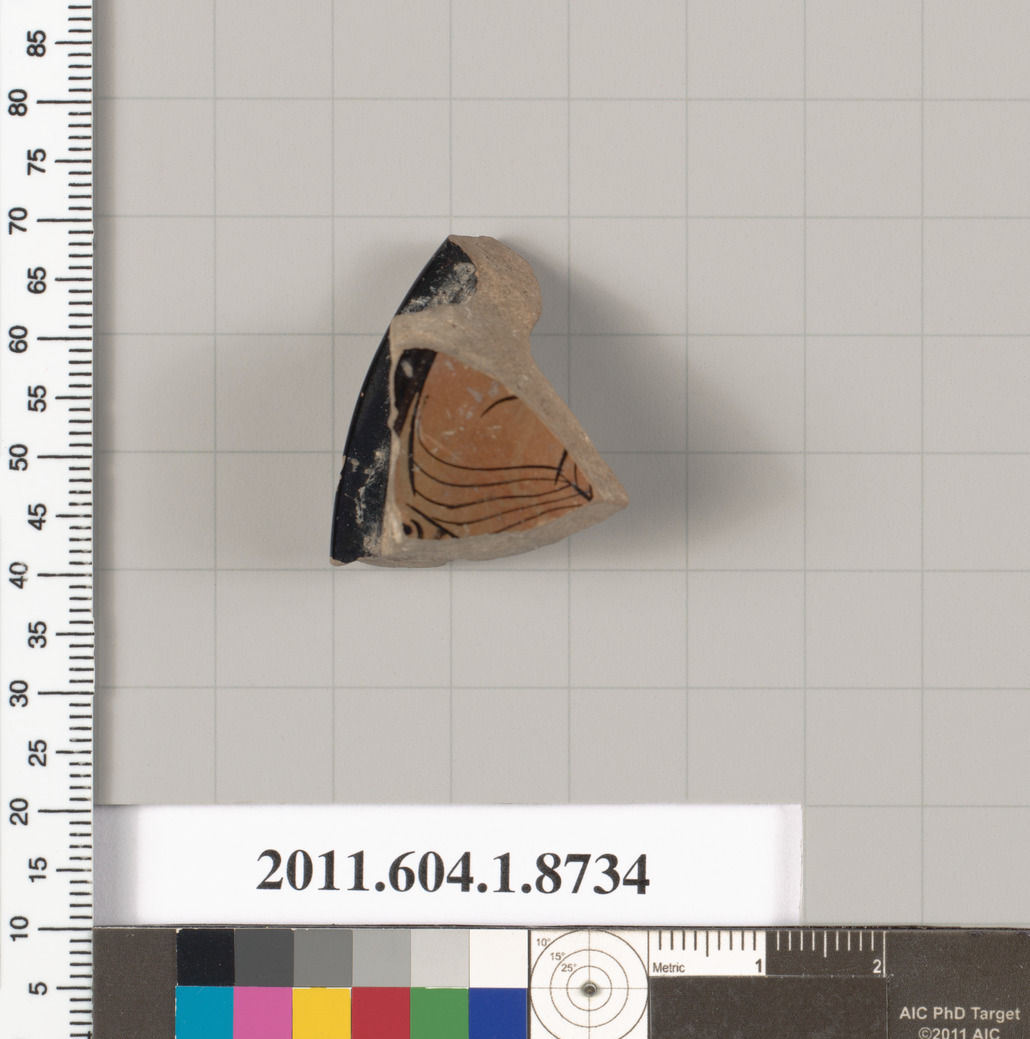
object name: kylix fragment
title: Terracotta fragment of a stemless cup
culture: greek, attic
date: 460-450 BCE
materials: terracotta